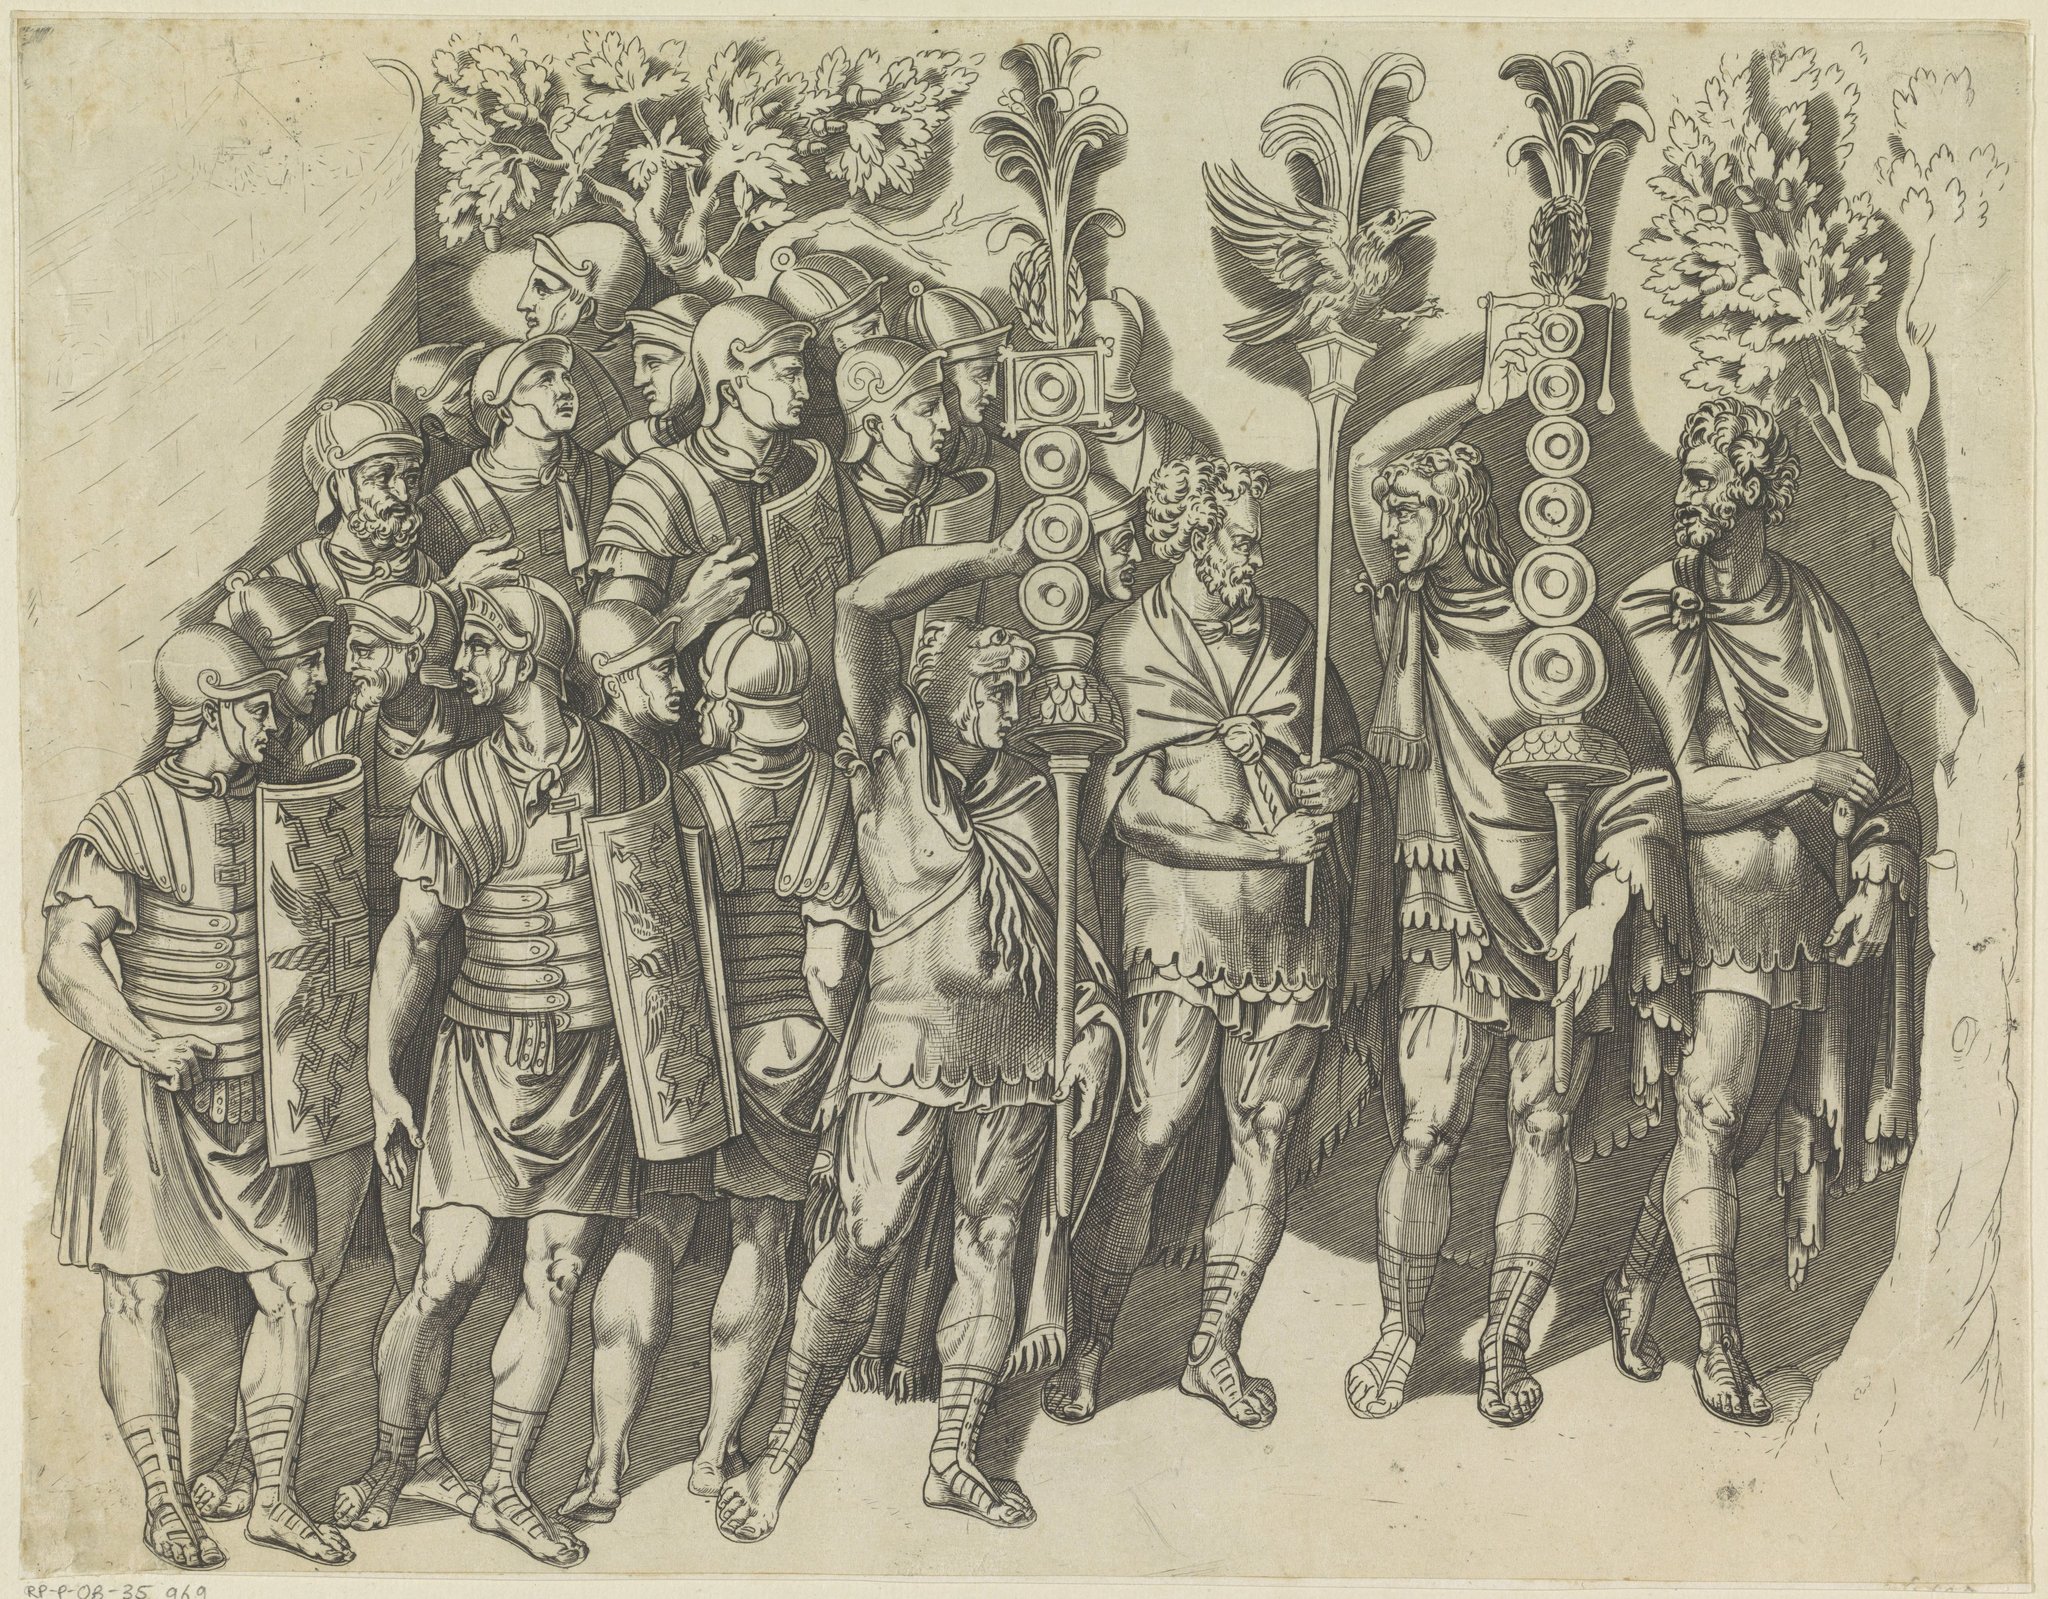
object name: print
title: Romeins legioen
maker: marco dente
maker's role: print maker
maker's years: 1486-1527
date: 1498-1532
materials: paper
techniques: engraving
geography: italy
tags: standard-bearer, flag-bearer, the soldier; the soldier's life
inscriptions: collector's mark: Lugt 12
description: Een legioen Romeinse soldaten met schilden en drie mannen die een draco (standaard) dragen.